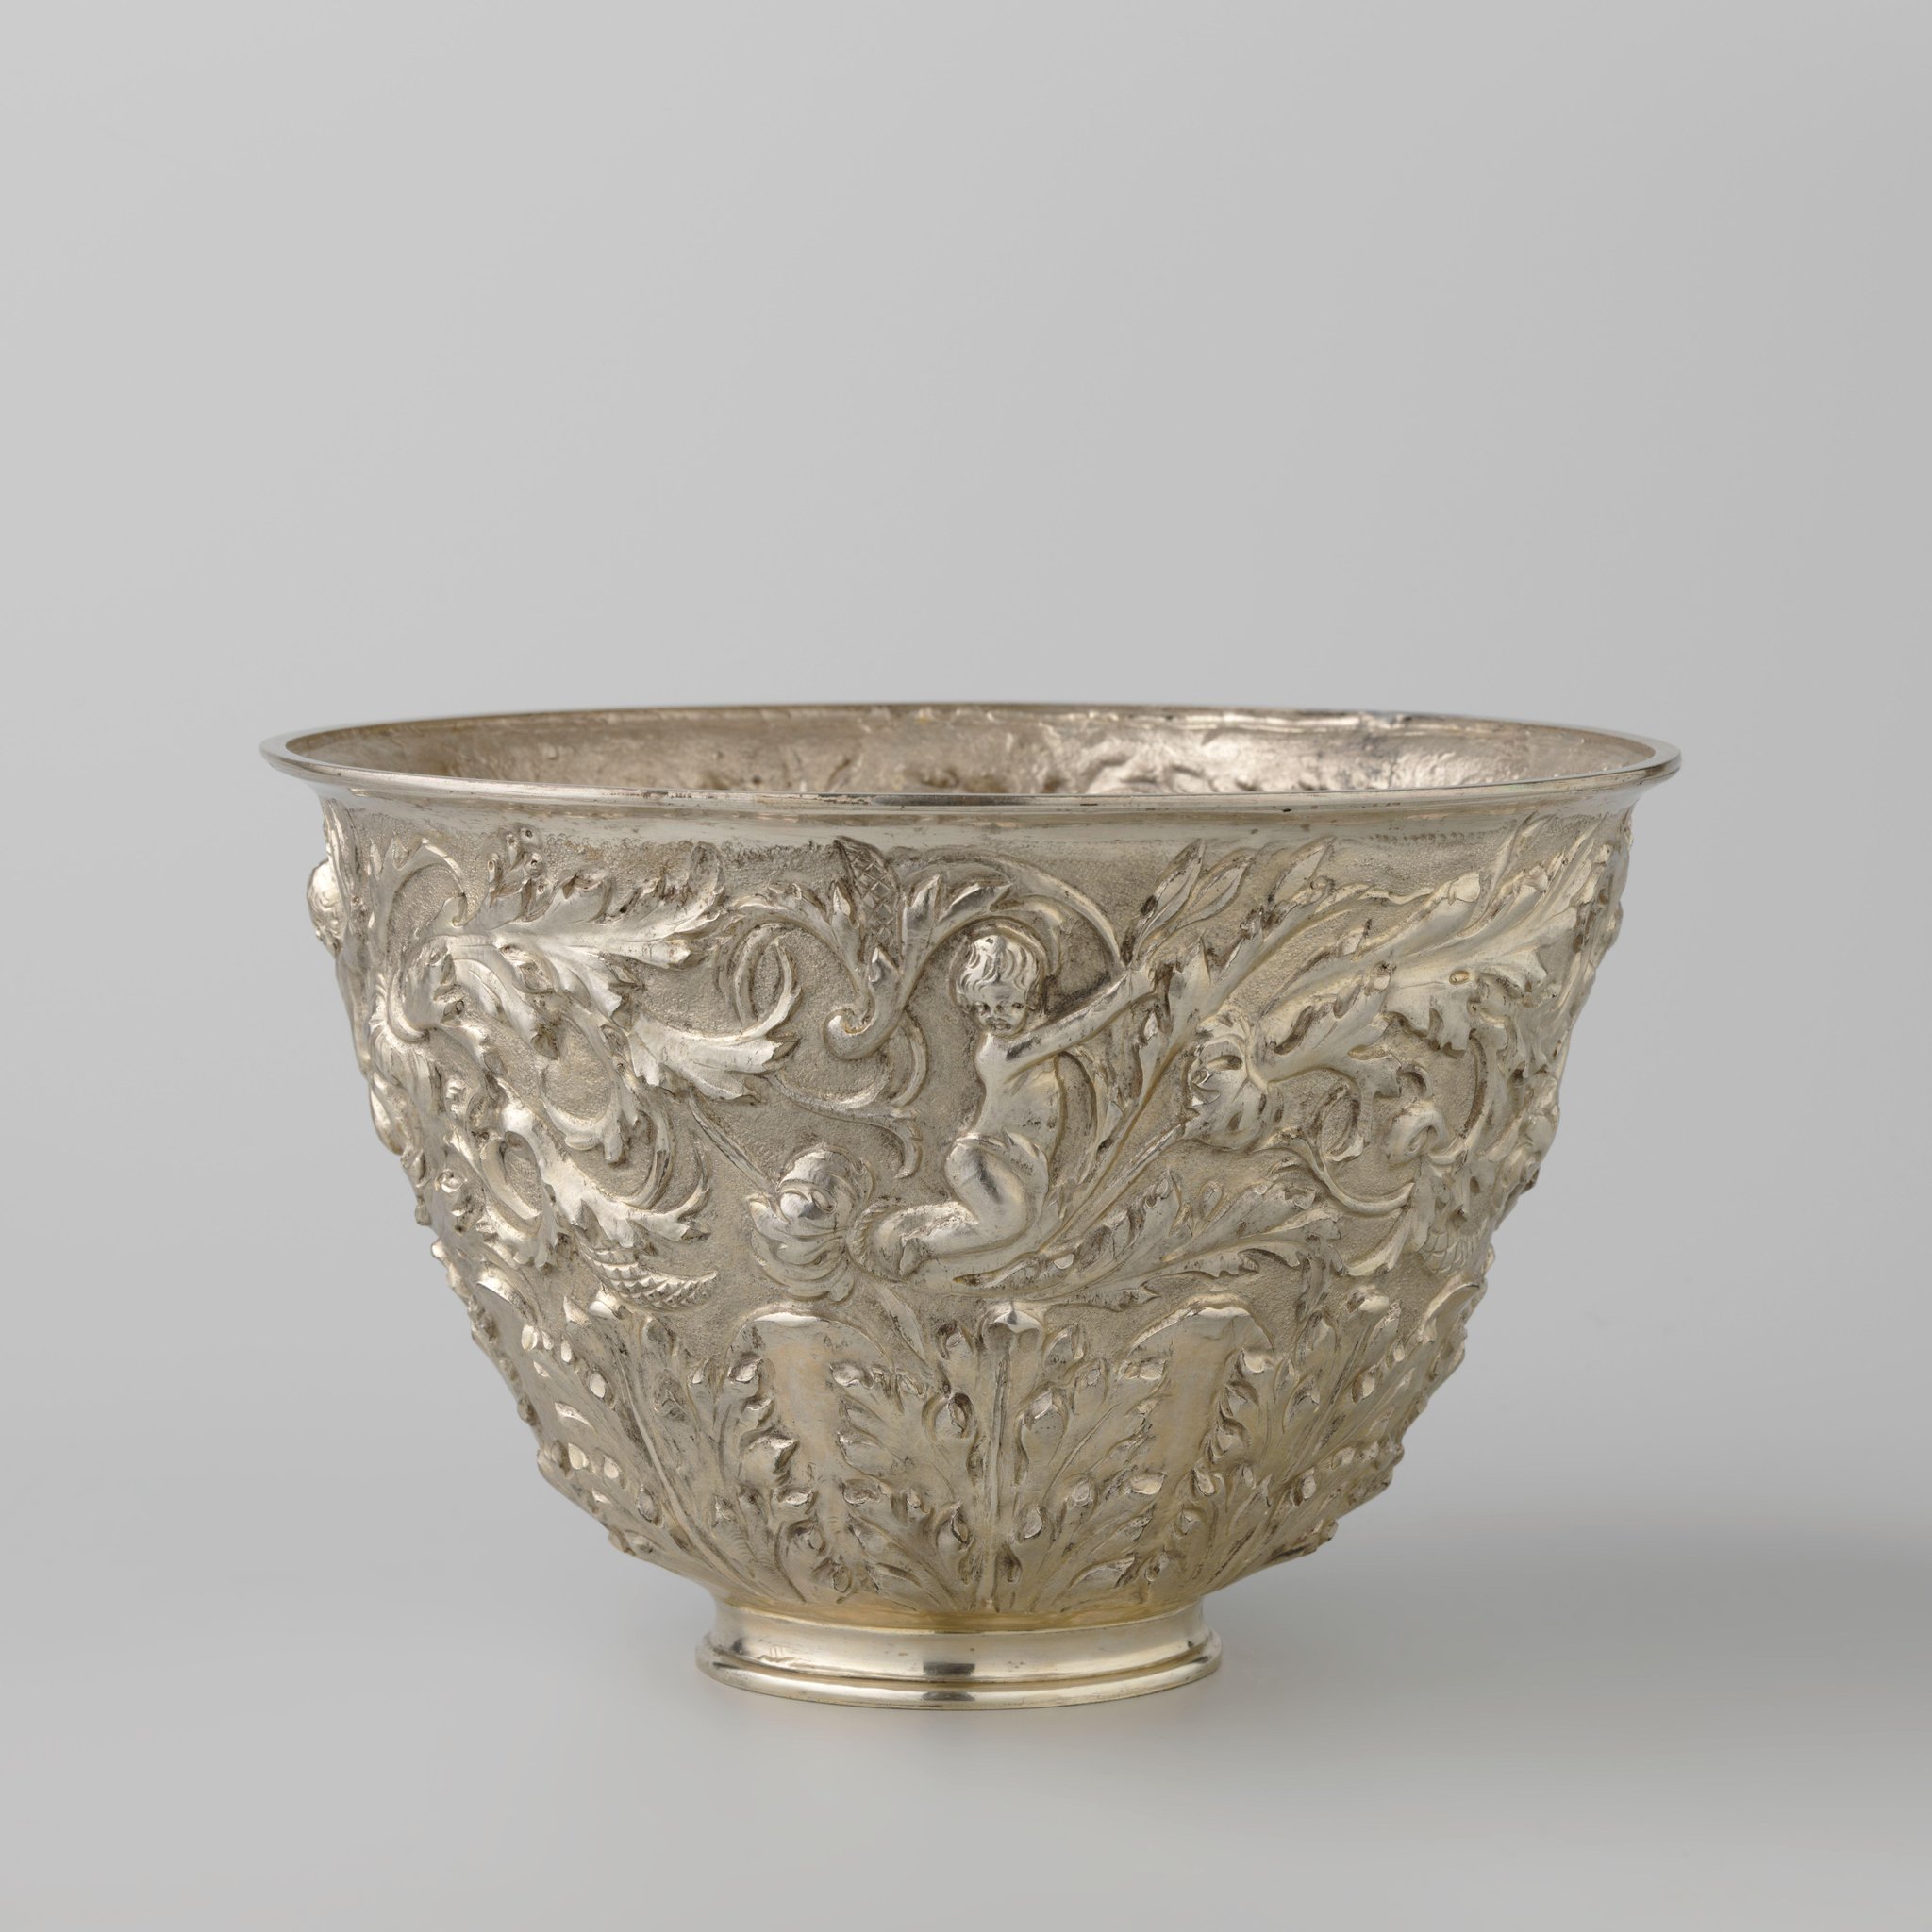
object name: bowl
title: Galvanoplastische reproductie van een kom met bladeren en kindertjes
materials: copper, silver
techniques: galvanoplasty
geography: london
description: Galvanoplastische reproductie van een kom met bladeren en kindertjes.